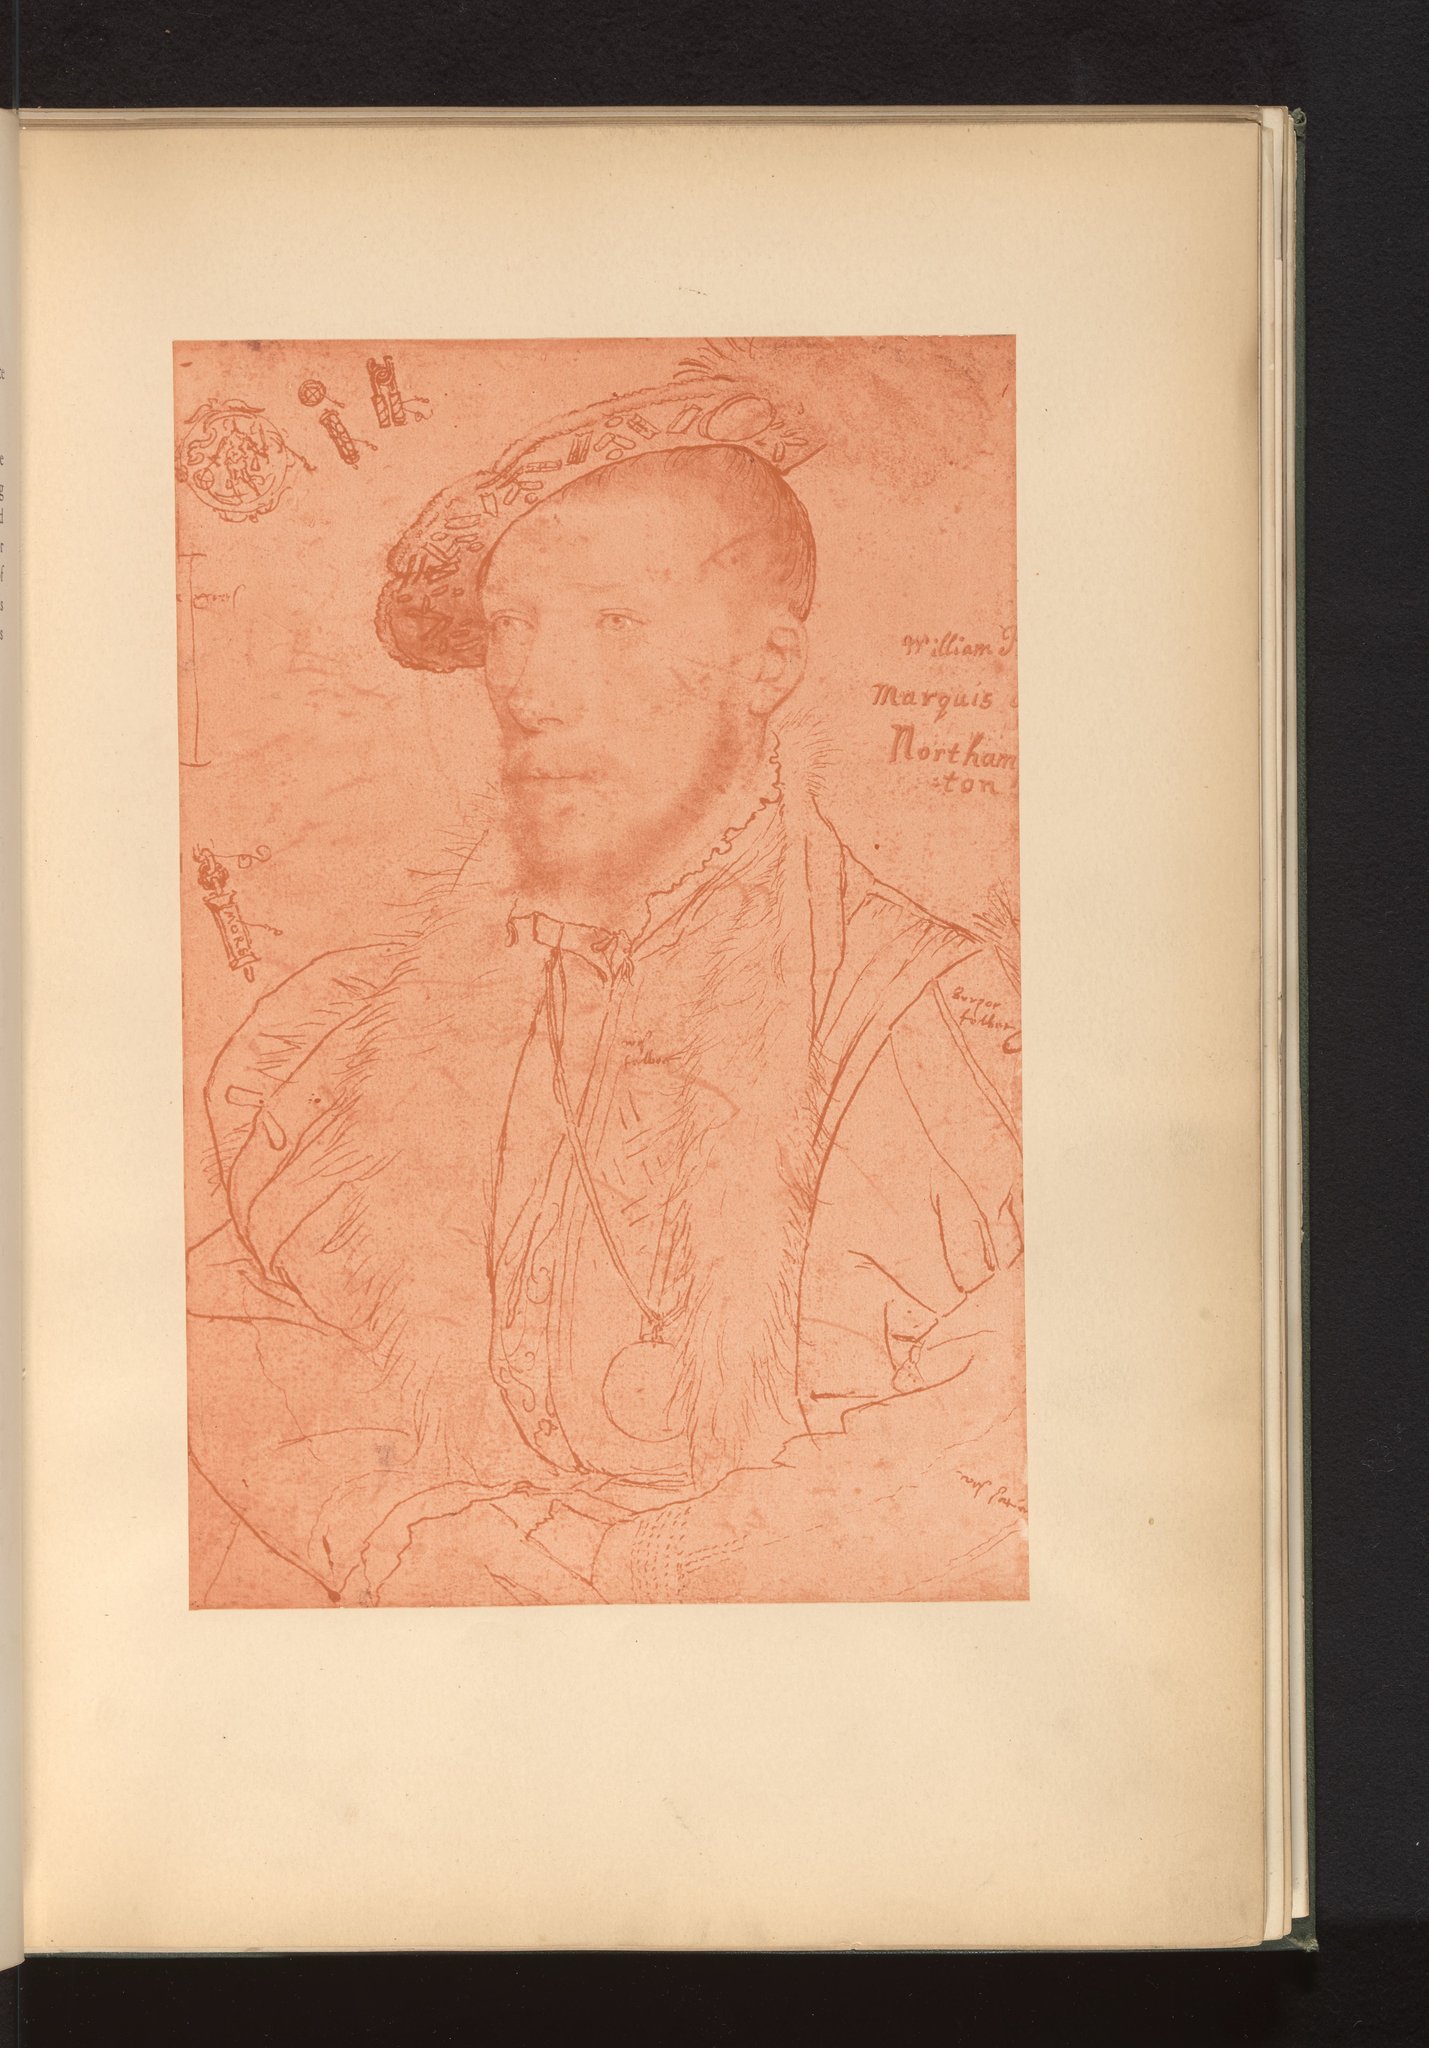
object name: photograph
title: Fotoreproductie van een portret van William Parr, markies van Northampton, door Hans Holbein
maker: Anonymous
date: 1872-1877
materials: paper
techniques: carbon print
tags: london, earl, drawing, sketch, historical persons